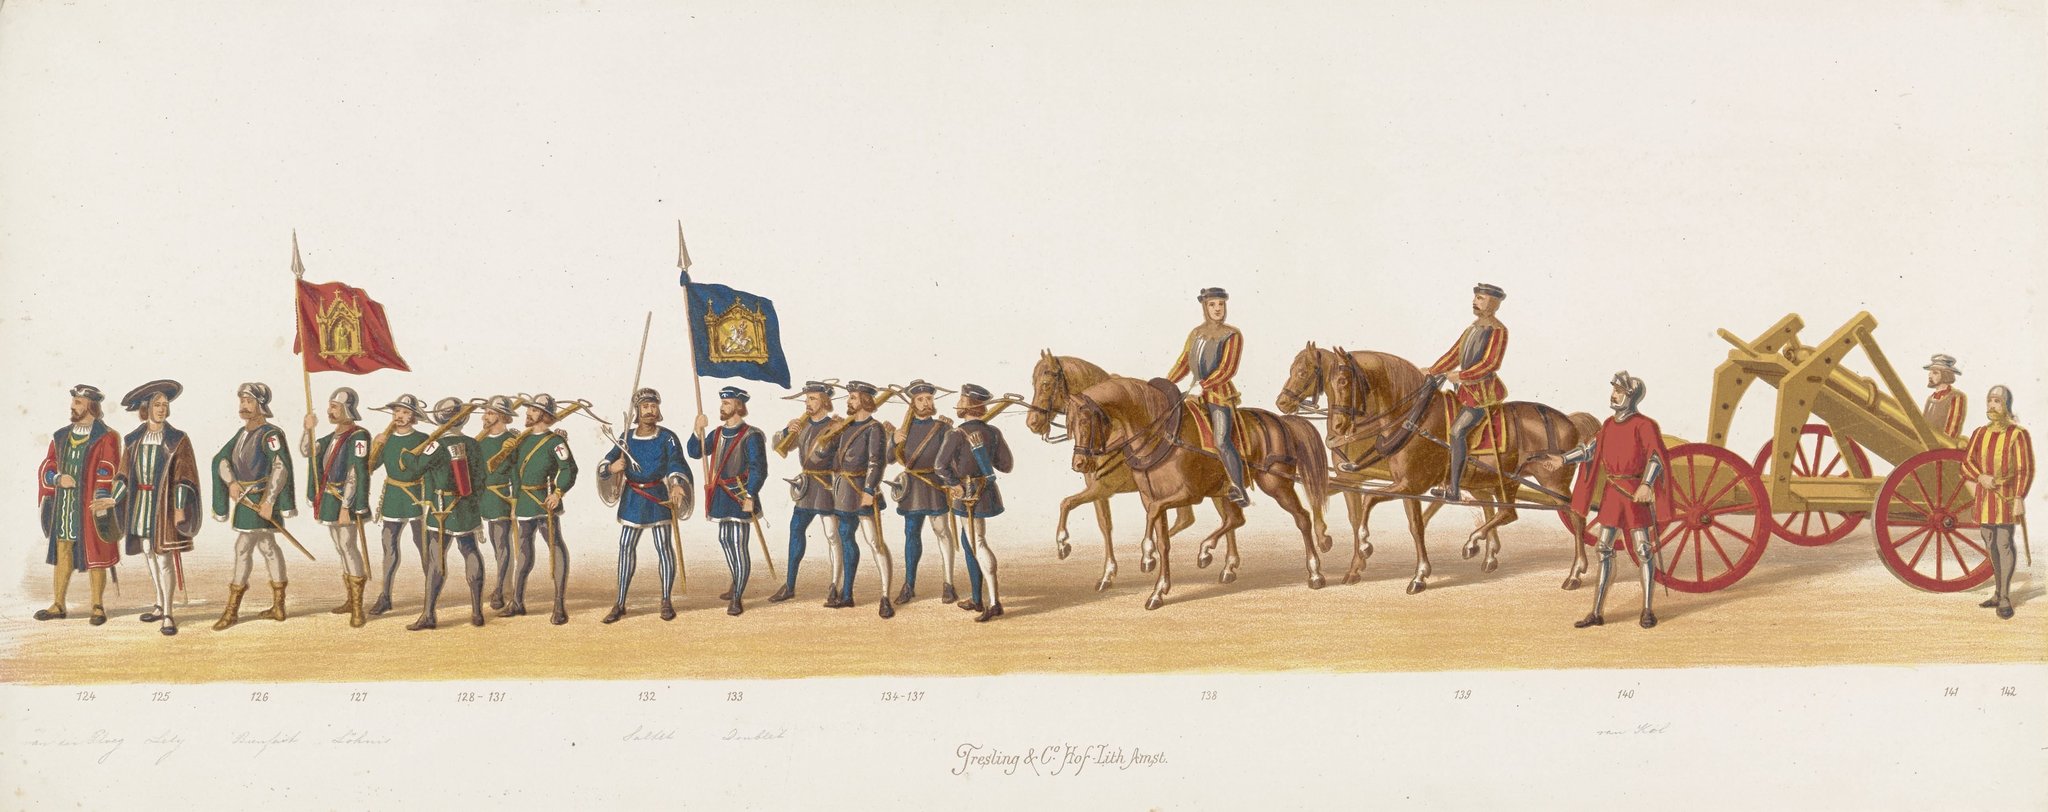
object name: print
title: Gecostumeerde optocht gehouden door de leden van het Delftsche Studentencorps op den 8 Juli 1873, voorstellende: den intocht van Karel van Egmond, hertog van Gelre, graaf van Zutphen, binnen Arnhem in 1492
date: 1873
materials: paper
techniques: chromolithography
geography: delft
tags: grave, arnhem, earl, karel van egmond, students' pageant, costumes used in pageants, delft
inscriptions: collector's mark: Lugt 2228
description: Negende plaat met de nummers 124-142, de namen van de studenten in potlood eronder geschreven. Onderdeel van de serie van tien aaneensluitende platen van de historische gekostumeerde optocht door de studenten van de Polytechnische Hogeschool van Delft op 8 juli 1873. De optocht verbeeldt de intocht van Karel van Egmond in Arnhem in 1492.